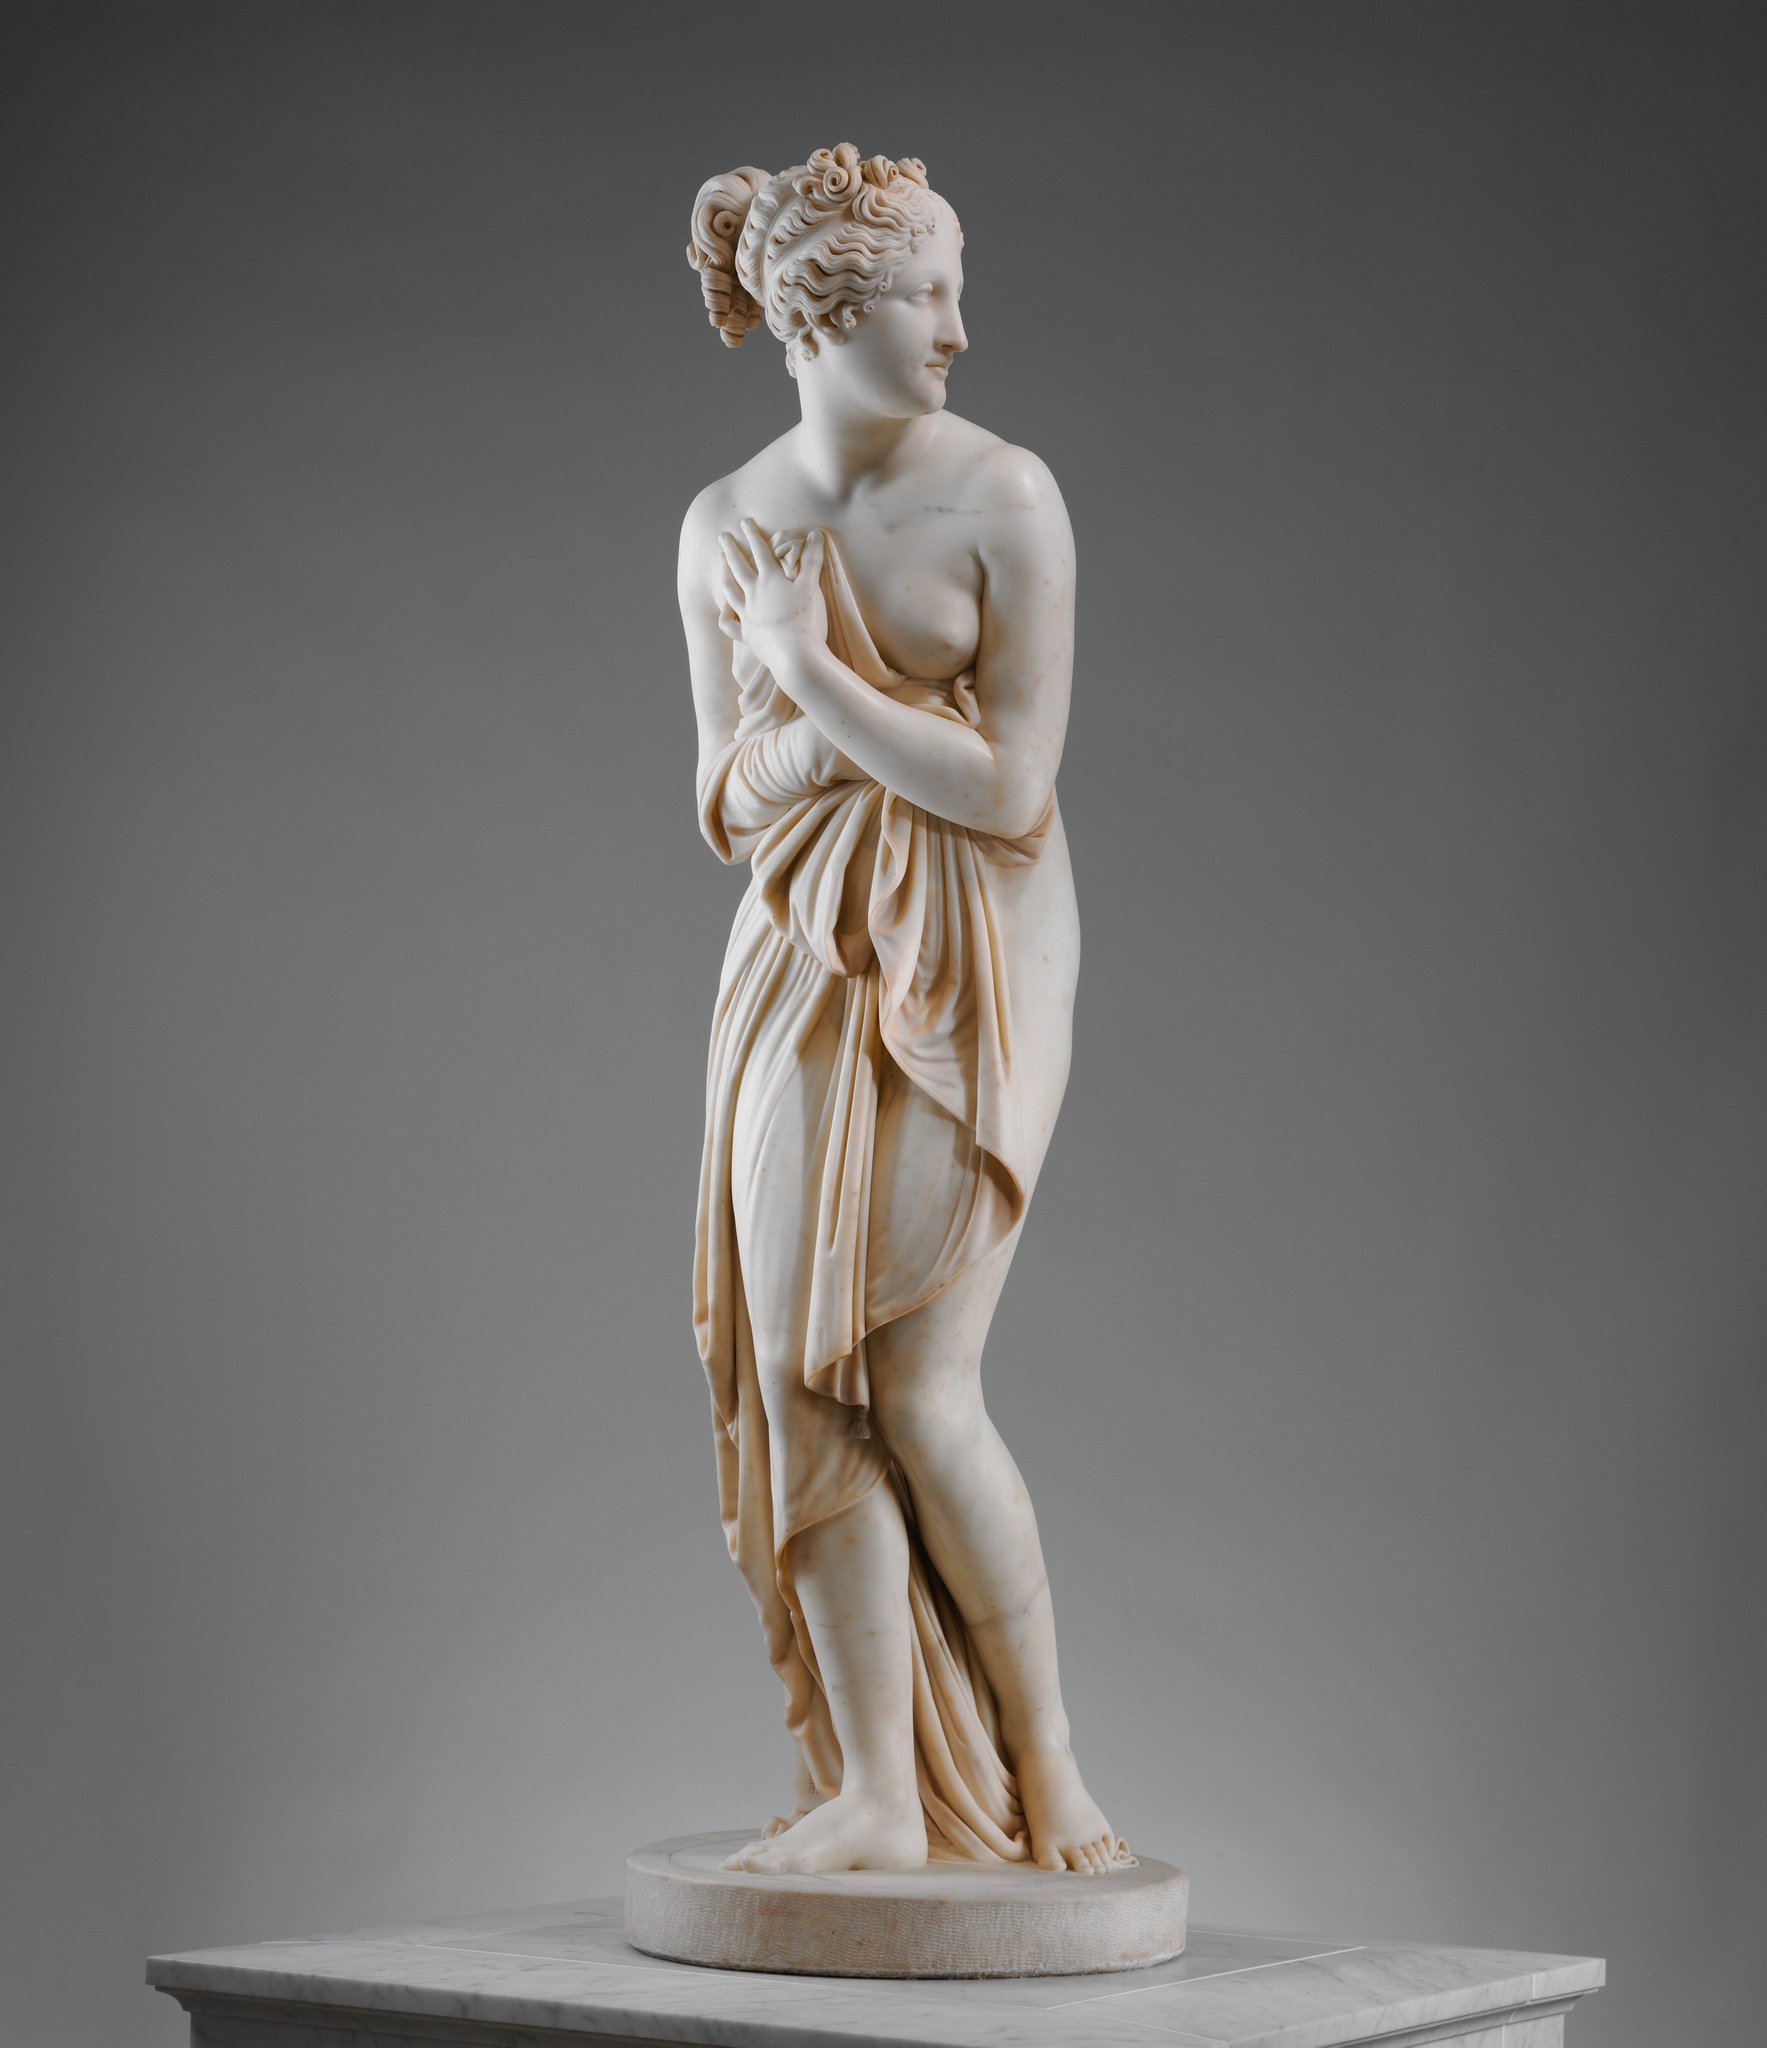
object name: statue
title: Venus Italica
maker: antonio canova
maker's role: artist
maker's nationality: italian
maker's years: 1757-1822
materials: marble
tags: female nudes,venus